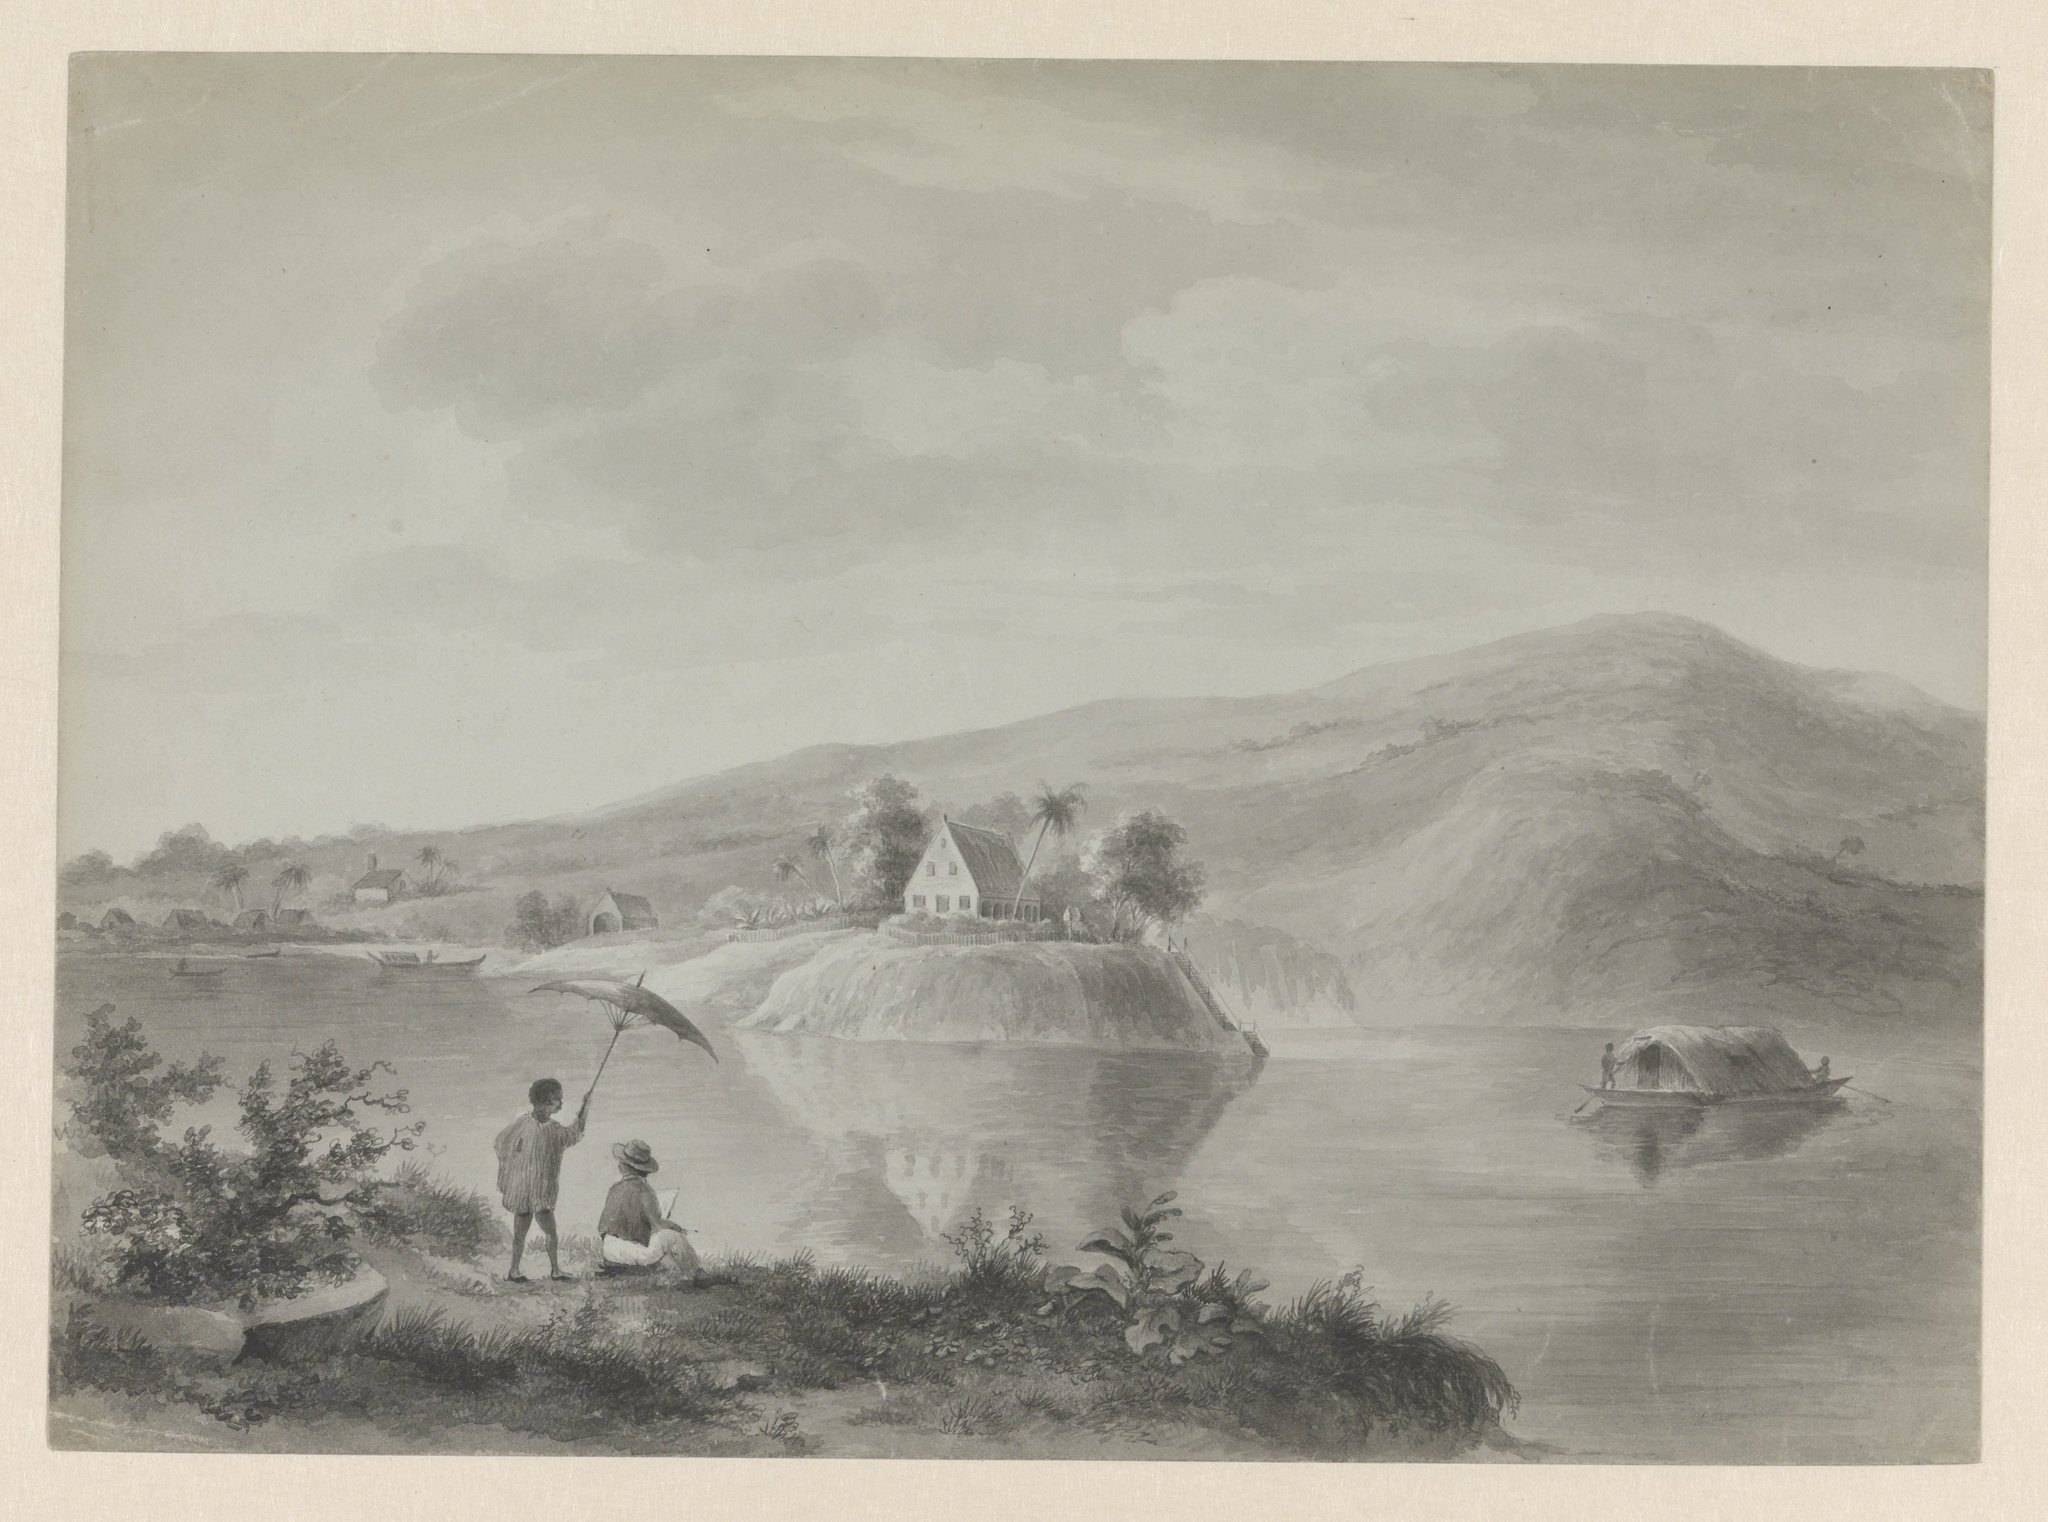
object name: drawing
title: Gezicht op een rivier met enkele huizen, mogelijk Berg en Dal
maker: hendrik huygens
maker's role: amateurtekenaar, officier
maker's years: 1810-1867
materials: paper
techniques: pen, brush in grey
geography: paramaribo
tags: plantation, slavery; serfs and enslaved persons, suriname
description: Gezicht op een rivier met aan de overkant enkele huizen en andere plantagegebouwen. Op de voorgrond is een tekenaar aan het werk terwijl een tot slaaf gemaakte man een parasol boven zijn hoofd houdt. Mogelijk heeft Huygens zichzelf hier afgebeeld. Op de rivier vaart een pondo, een klein vrachtschip met een dak van bananenbladeren. Mogelijk is hier Plantage Berg en Dal voorgesteld.